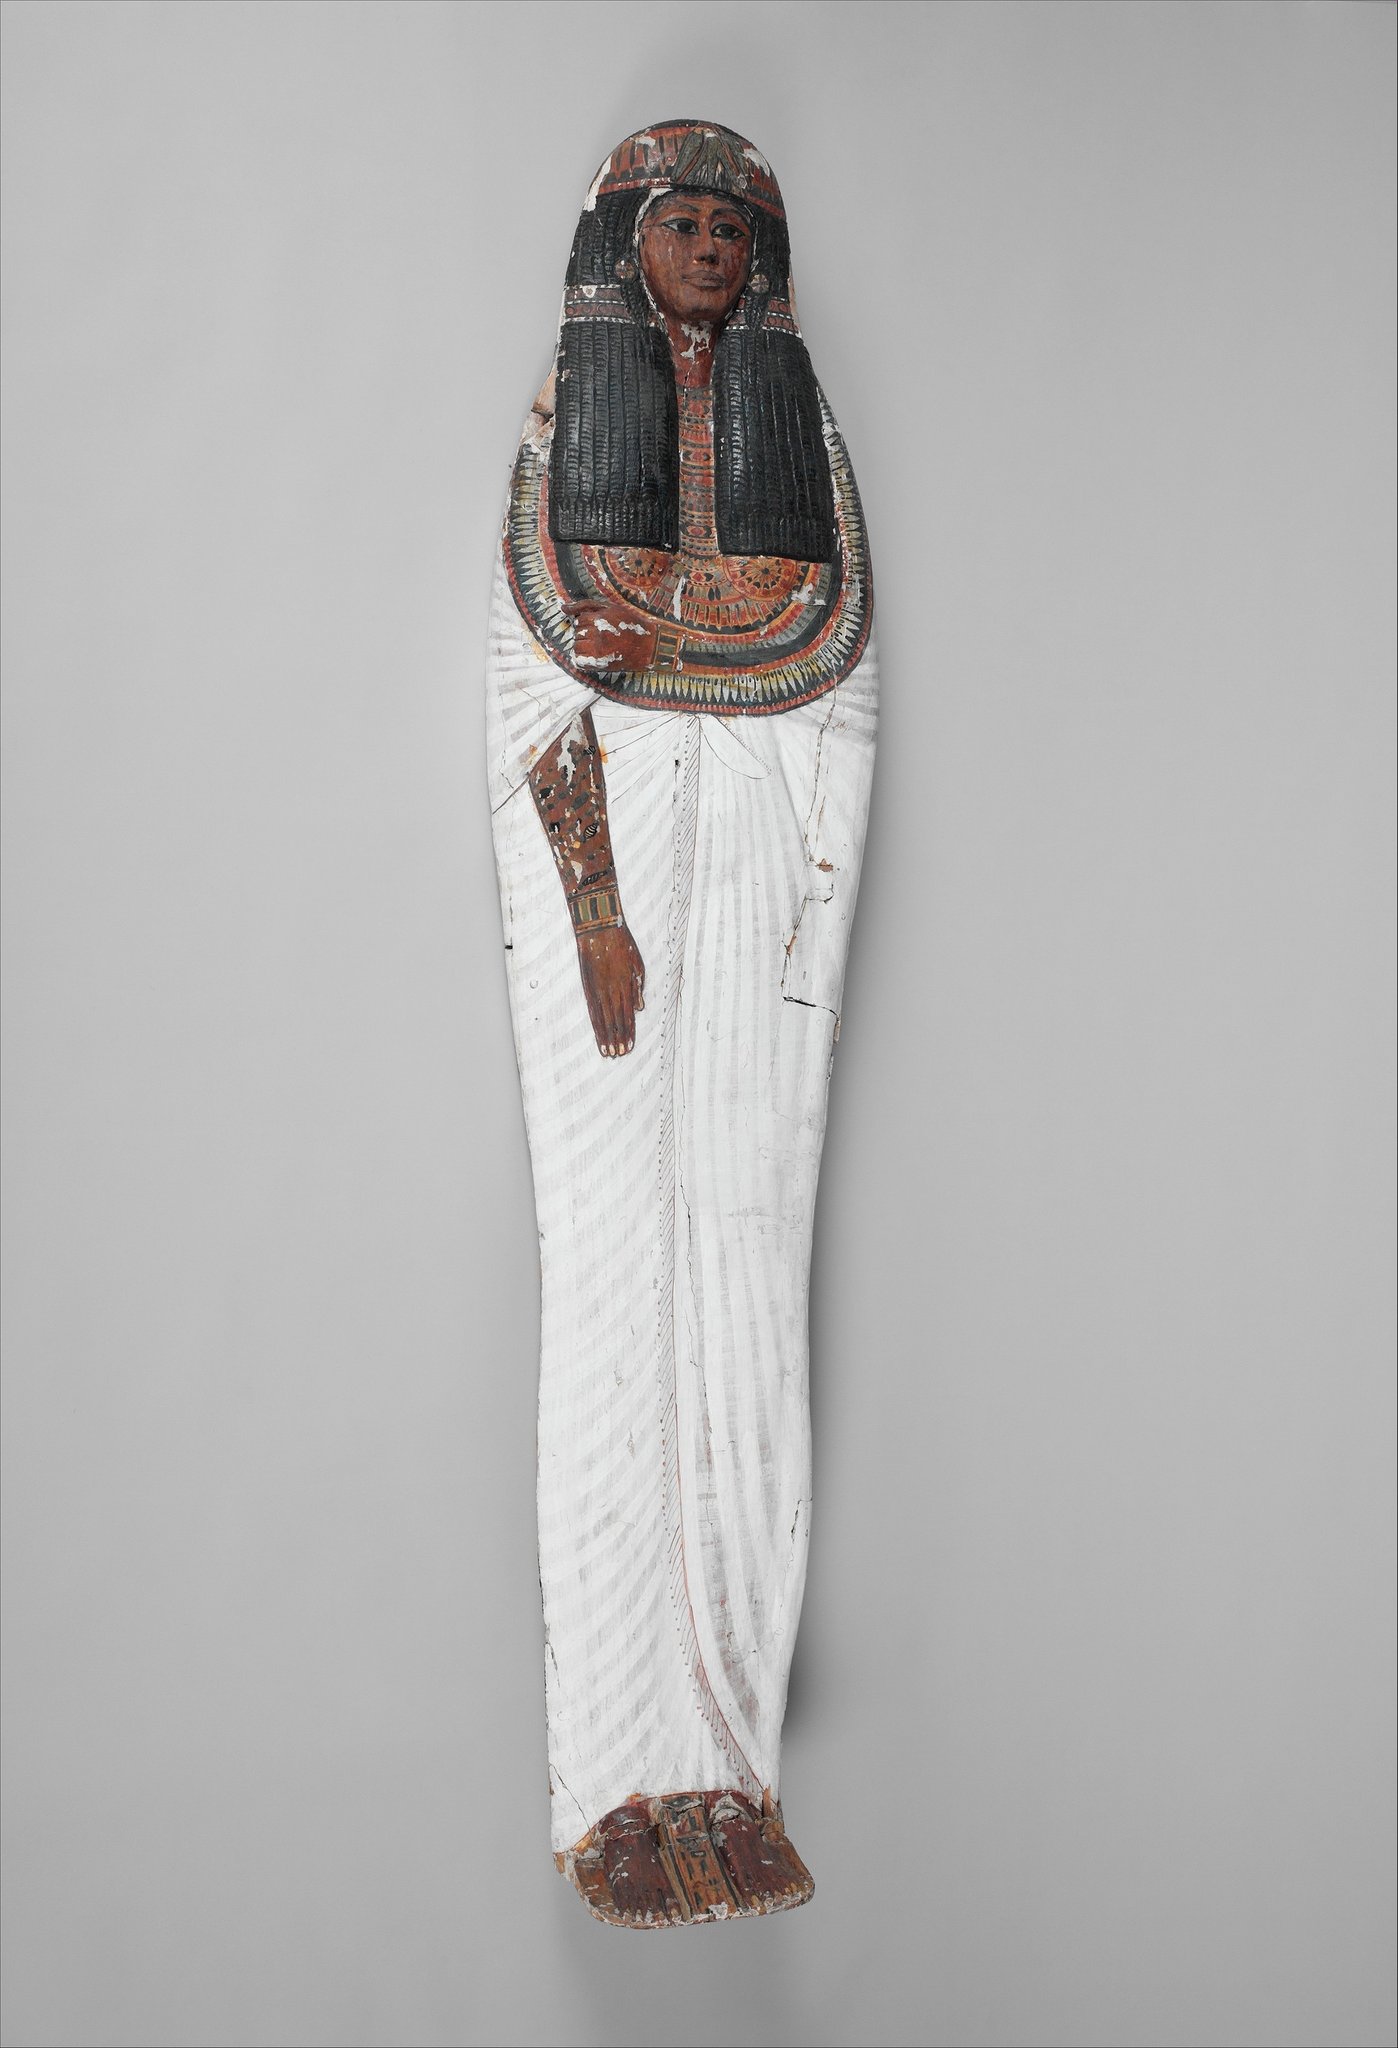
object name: mummy board, iineferty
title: Mummy Board of Iineferty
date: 1279-1213 BCE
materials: gesso, paint, varnish, wood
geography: egypt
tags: women